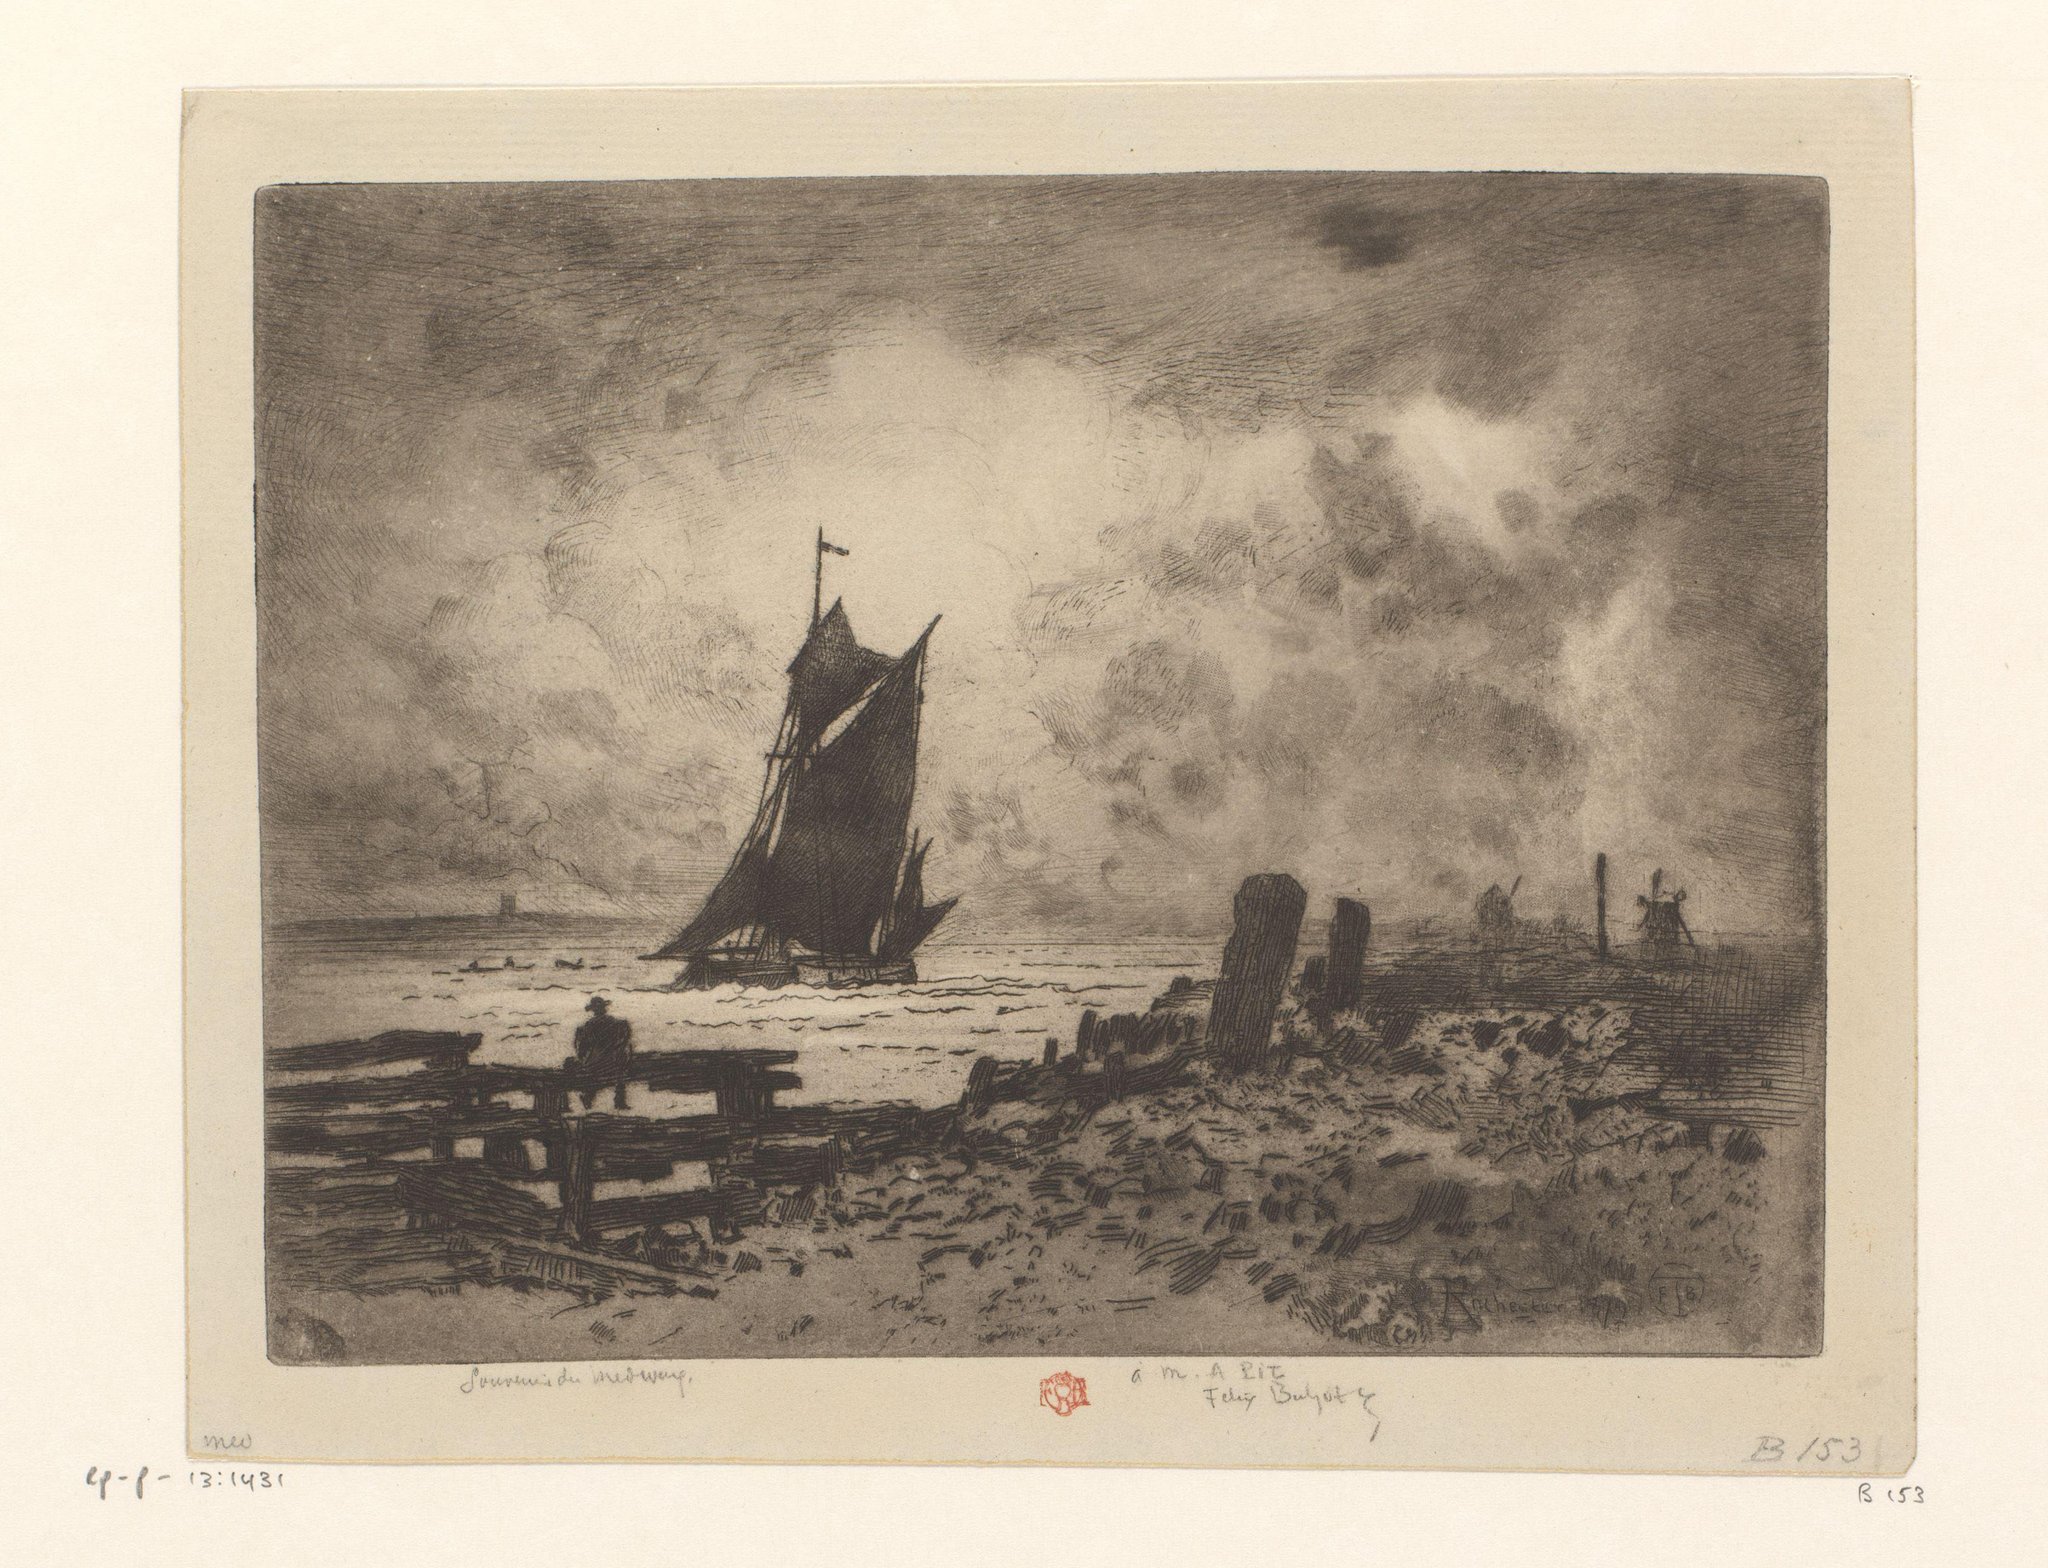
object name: print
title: Zeegezicht met schip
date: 1879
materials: paper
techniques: aquatint, etching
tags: sea (seascape), ships (in general) - cc - more than one ship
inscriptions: signature: ‘à A. Pit Felix Buhot’, number: ‘B 153’, collector's mark: Lugt 977, : ‘Souvenir de Medway’, collector's mark: Lugt 2233